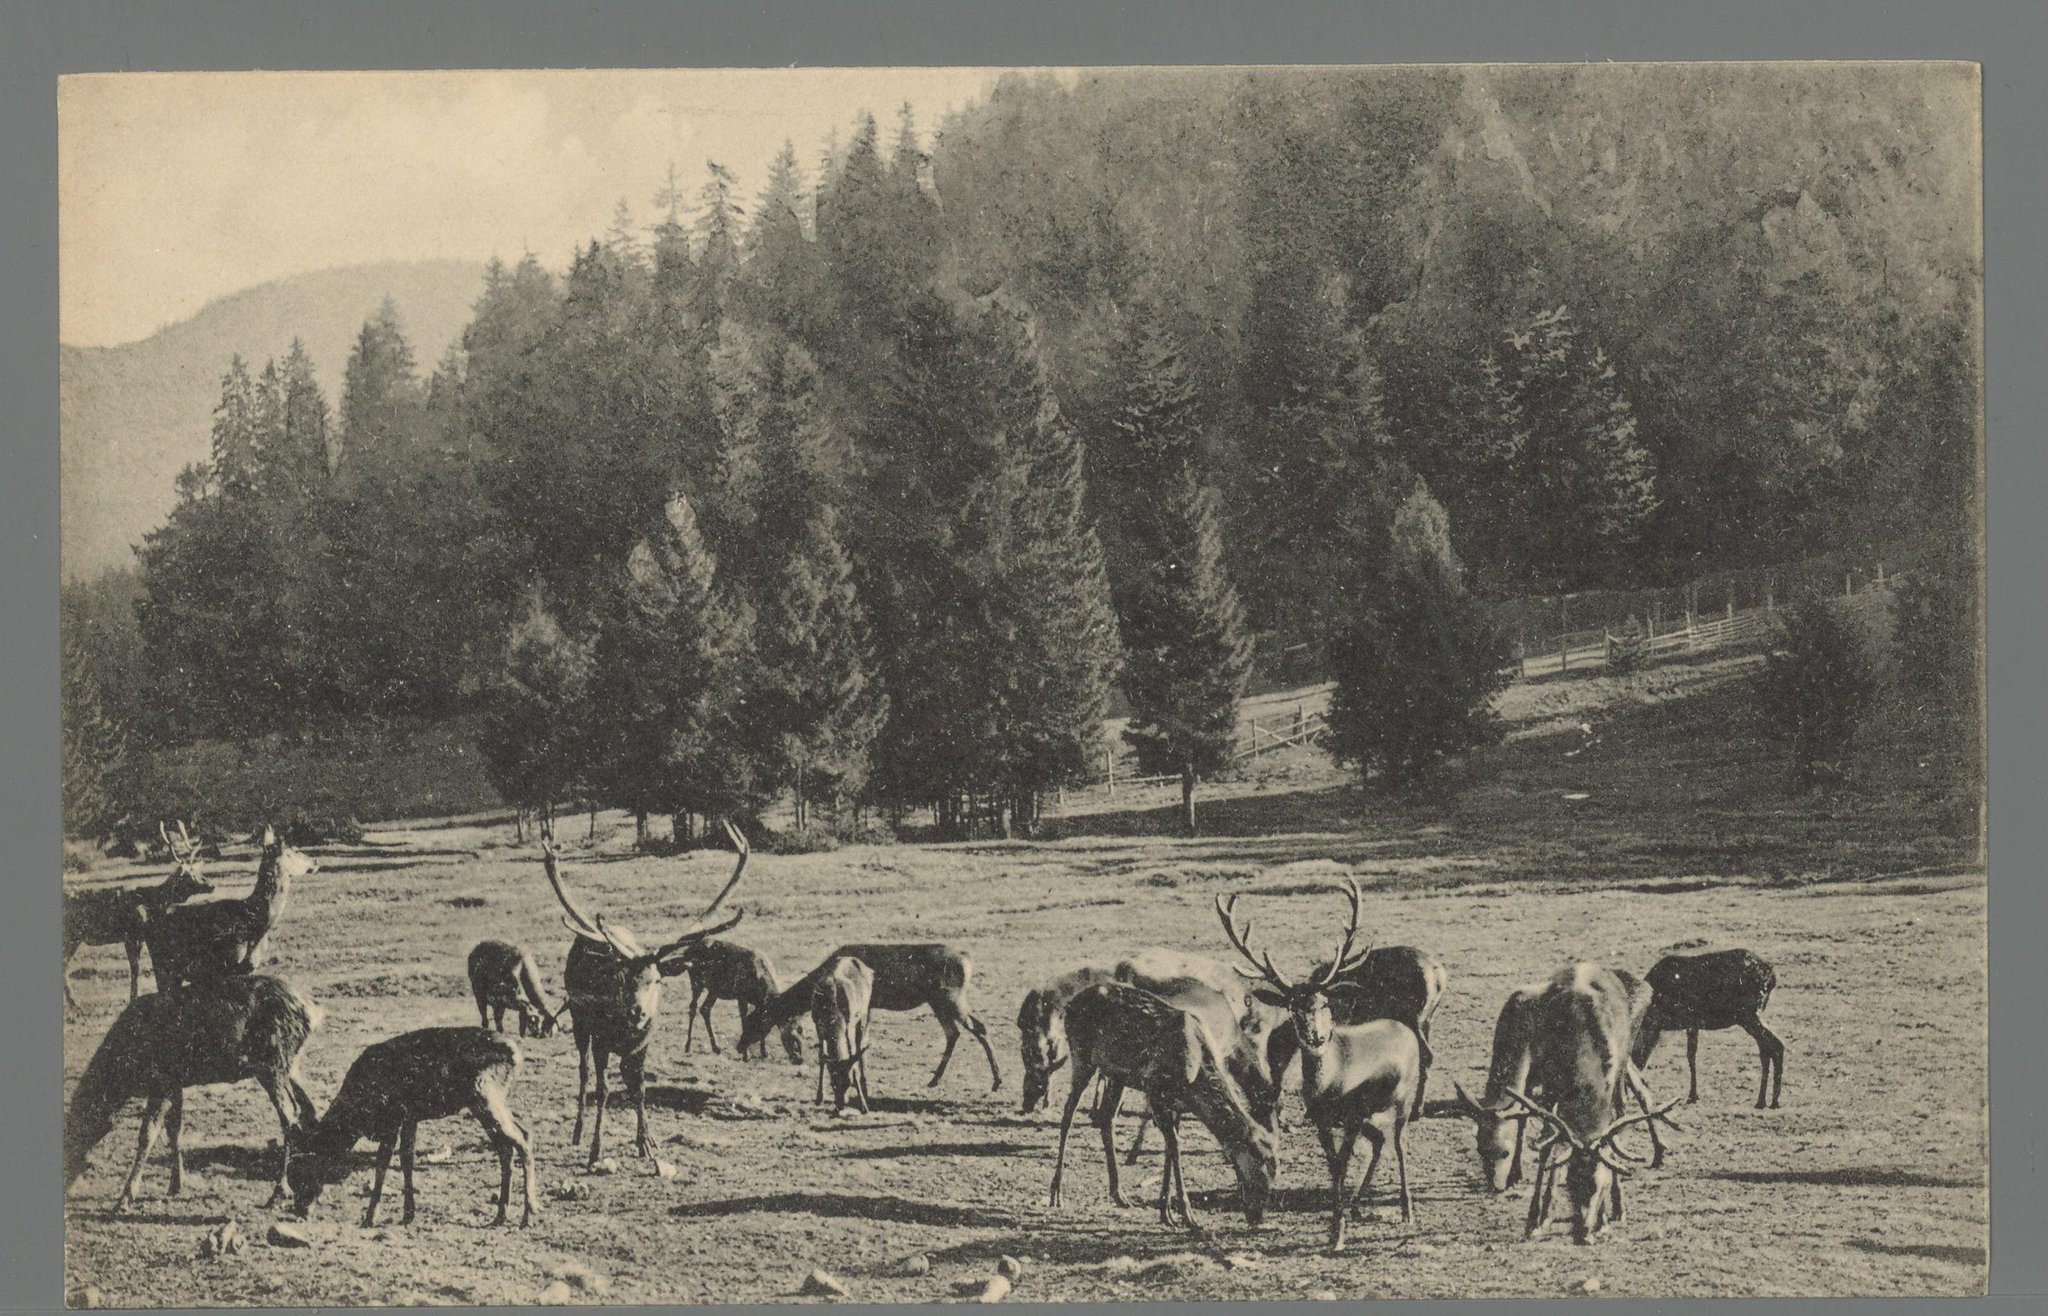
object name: photomechanical print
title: Gezicht op herten in een berglandschap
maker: karl thomass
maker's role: lithograaf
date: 1905-1909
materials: cardboard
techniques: photograph, writing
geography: gehren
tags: dale, valley, hoofed animals: deer, germany